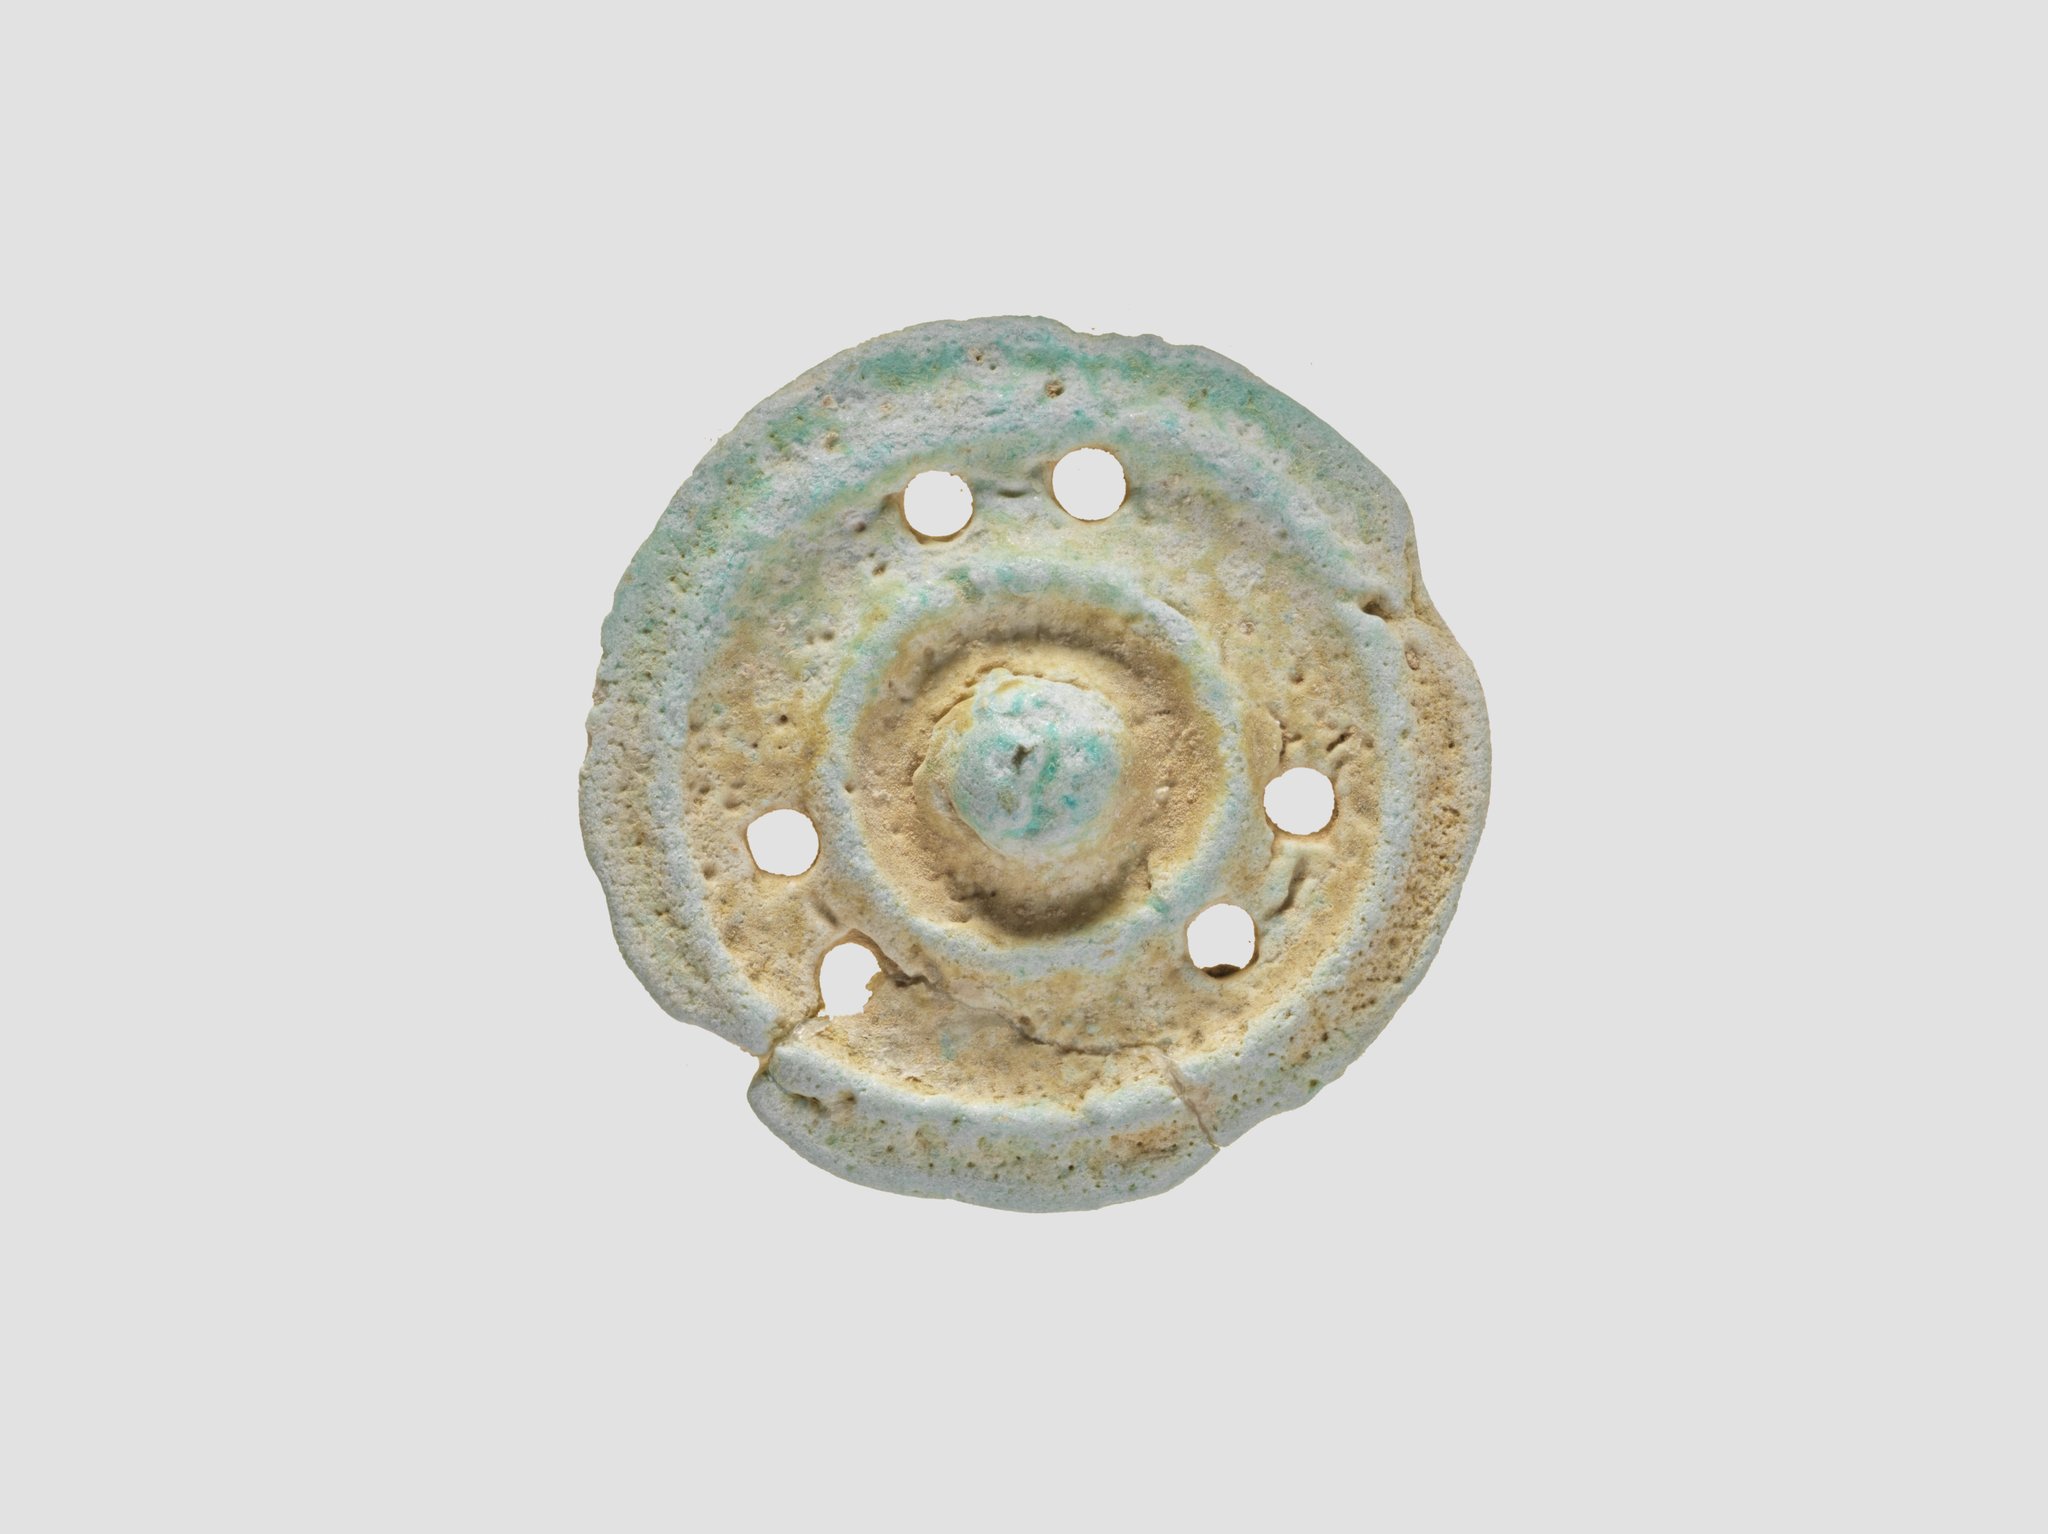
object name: ornament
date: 2333-2001 BCE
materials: faience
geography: mesopotamia